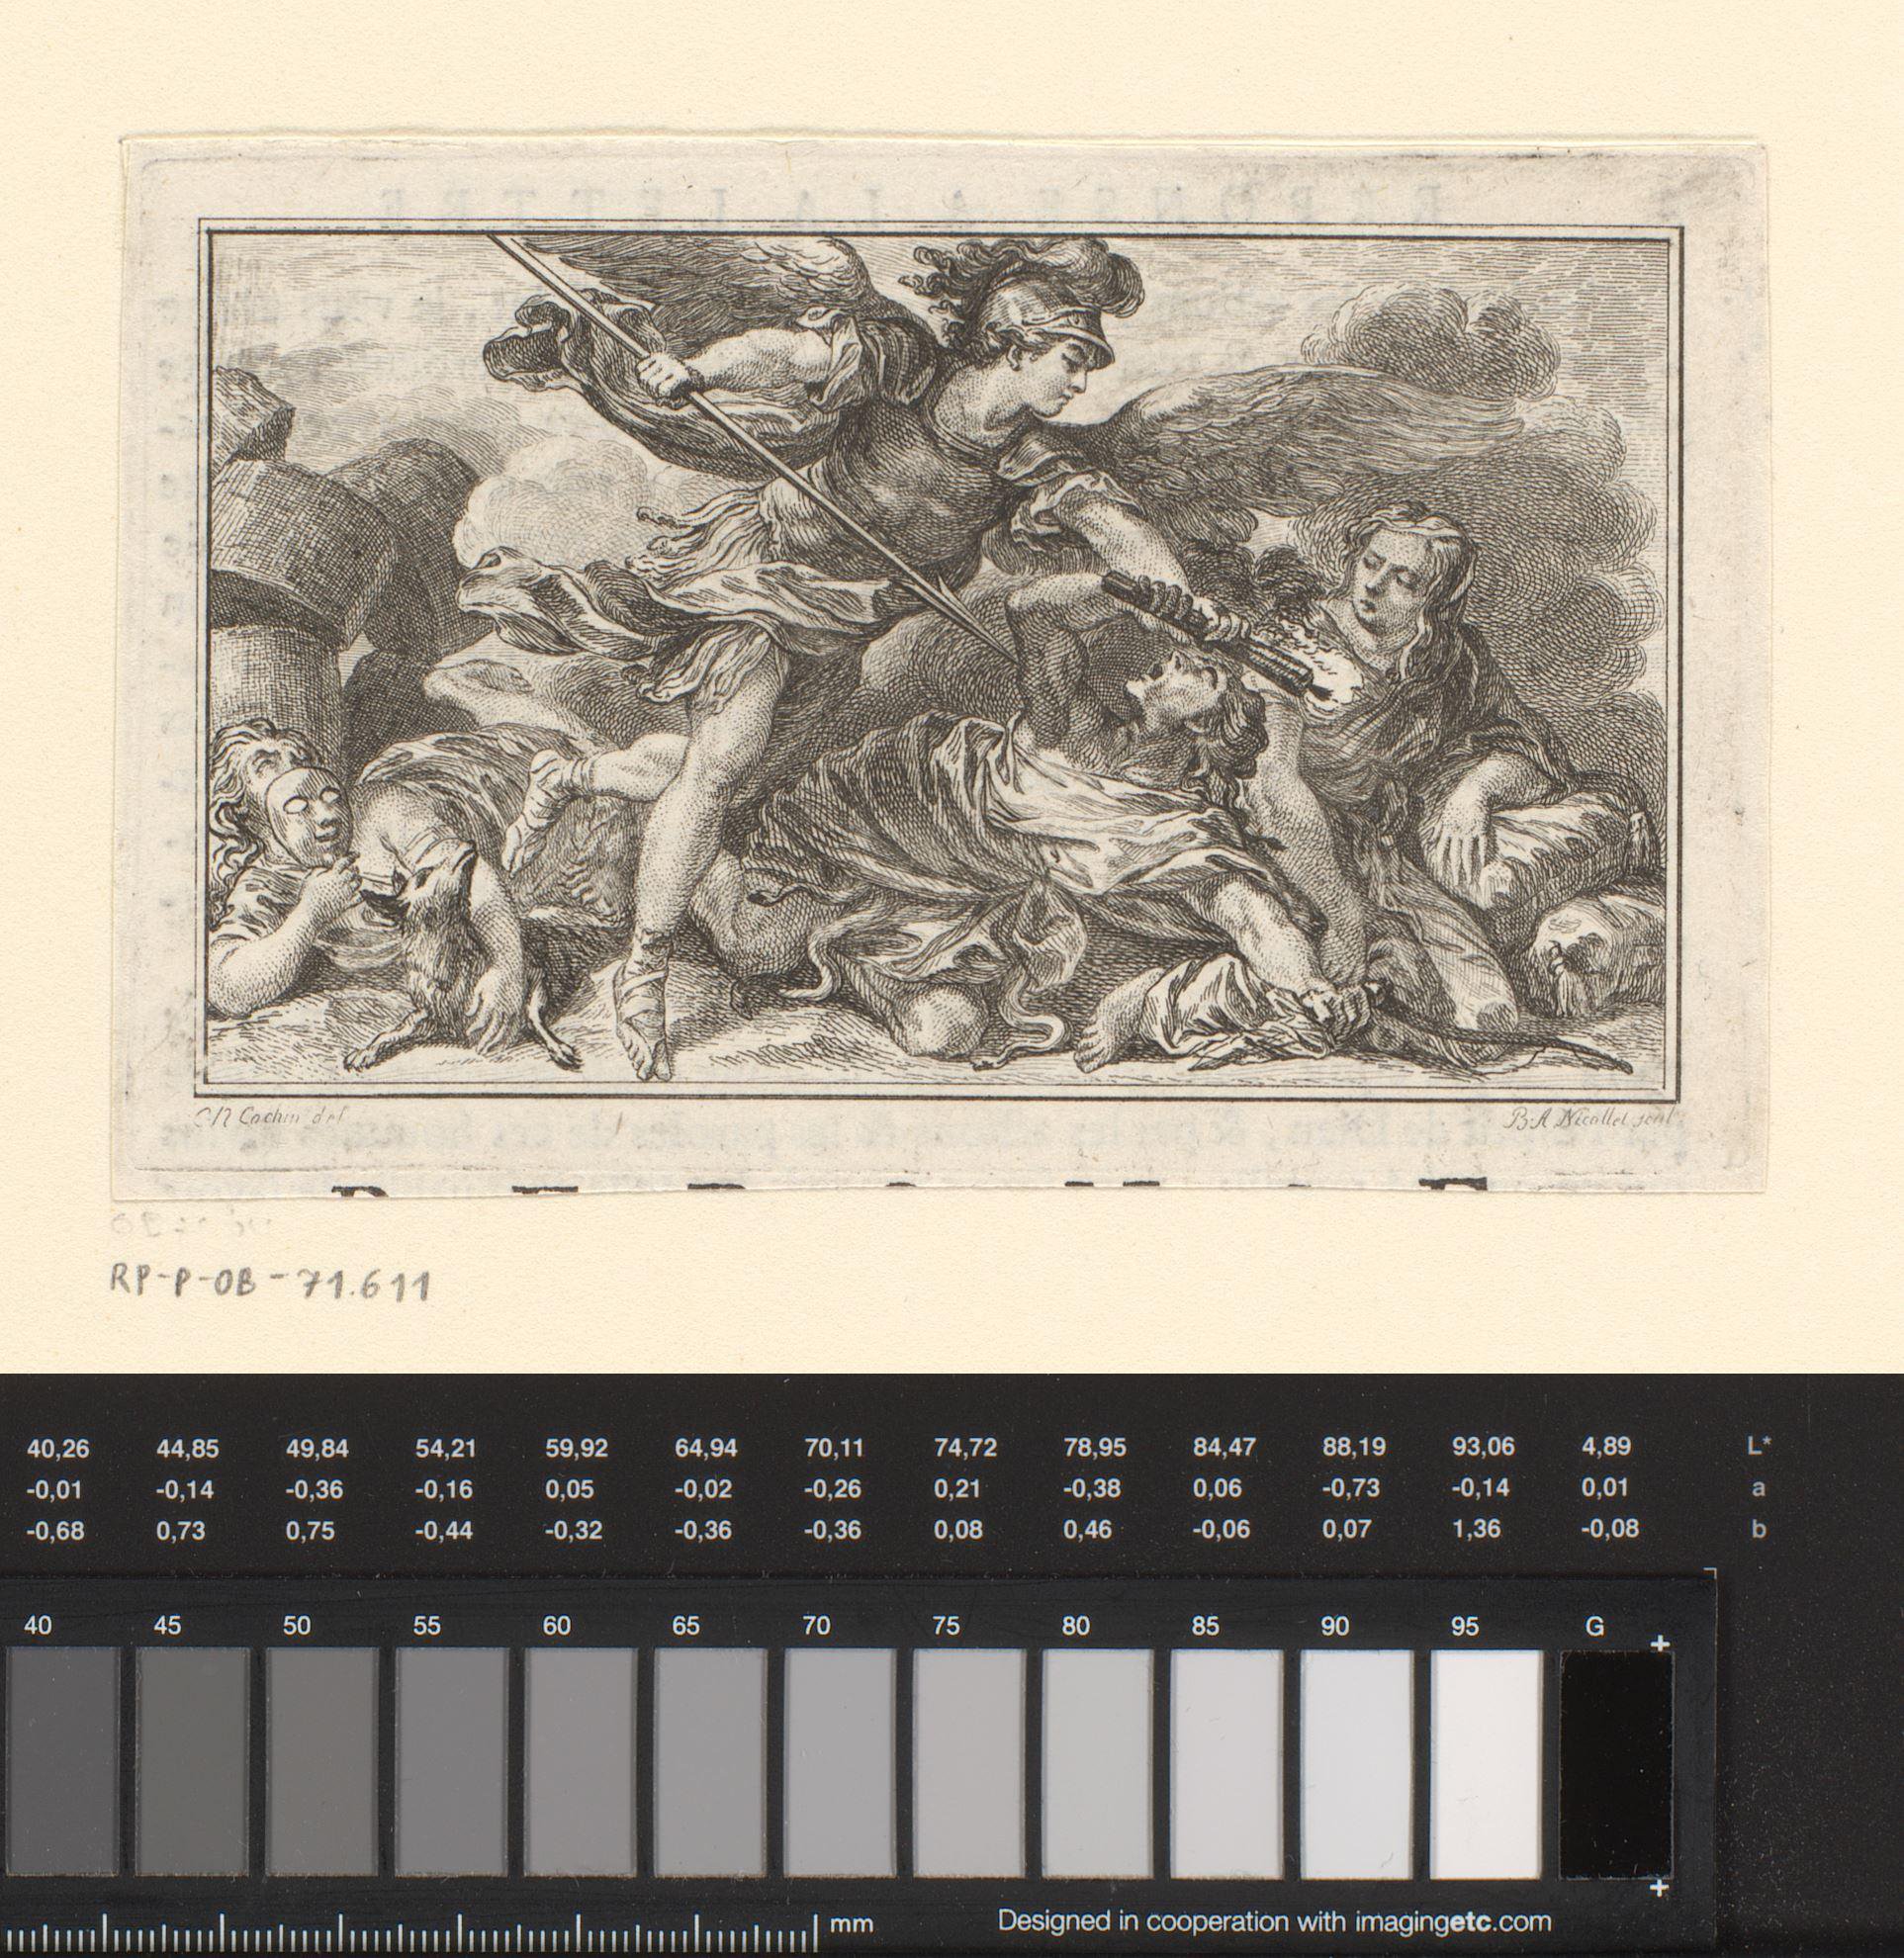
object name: print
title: Mars bedwingt een vrouw met toorts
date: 1753-1806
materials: paper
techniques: etching, letterpress printing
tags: (story of) mars (ares)